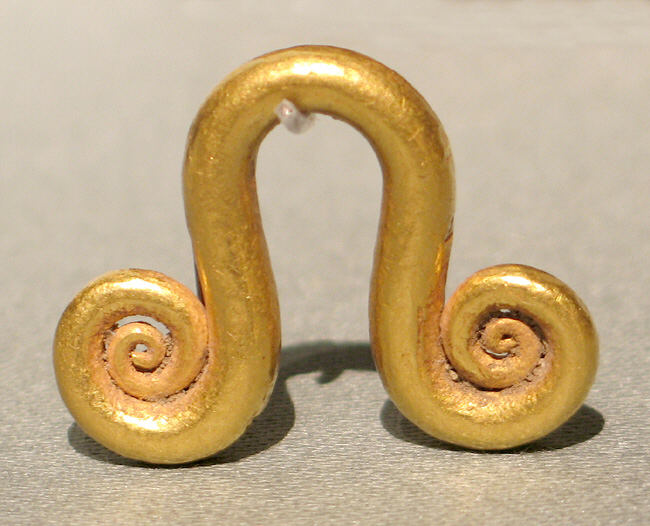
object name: earring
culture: indonesian, javanese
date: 701-833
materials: gold